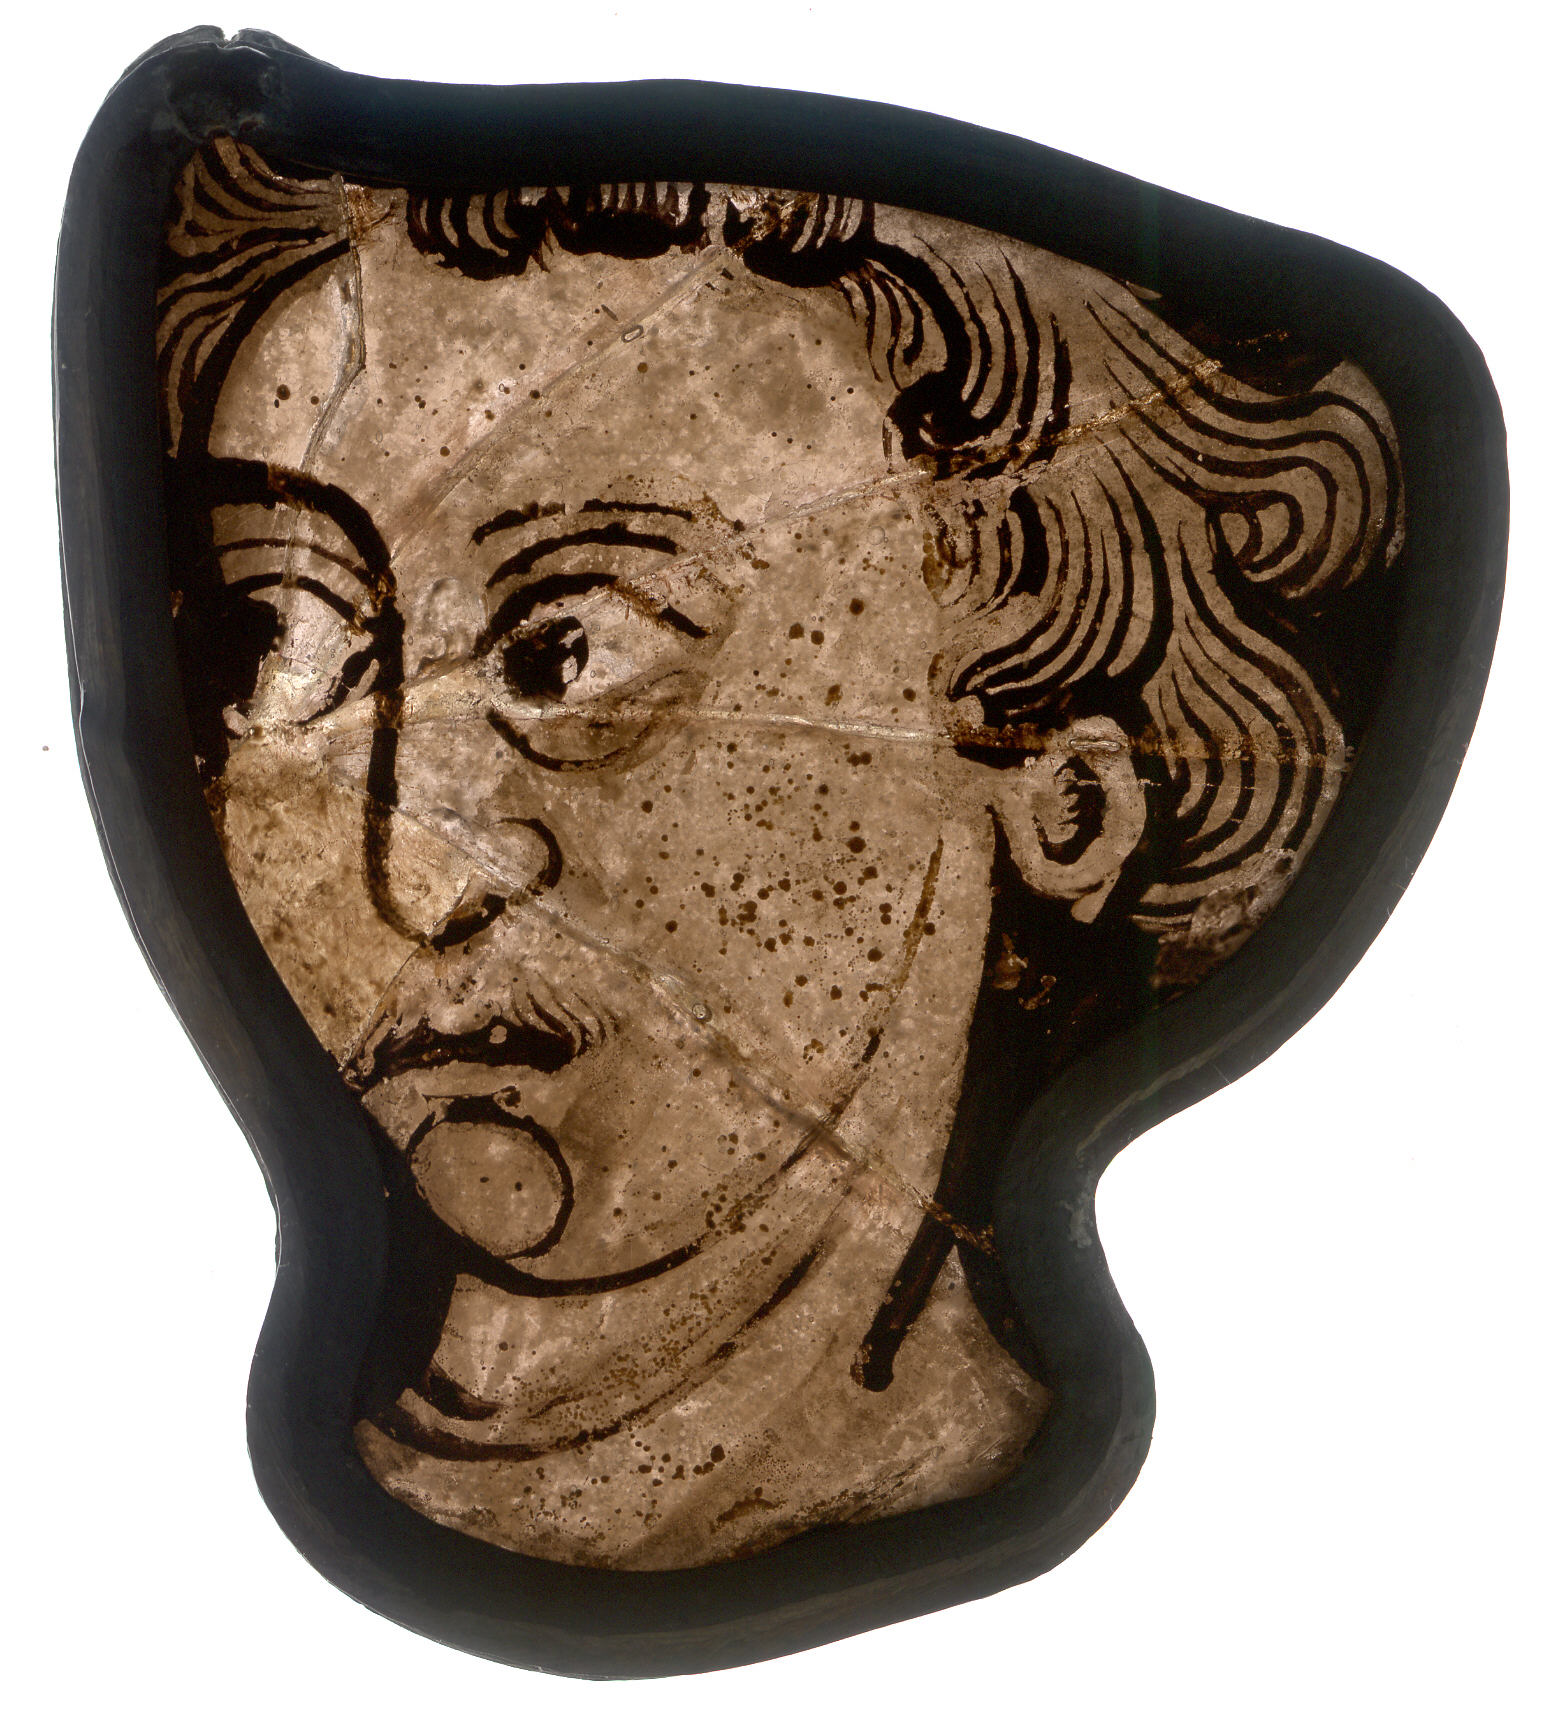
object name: fragment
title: Glass Fragment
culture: french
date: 1200-1215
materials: glass, metal, paint